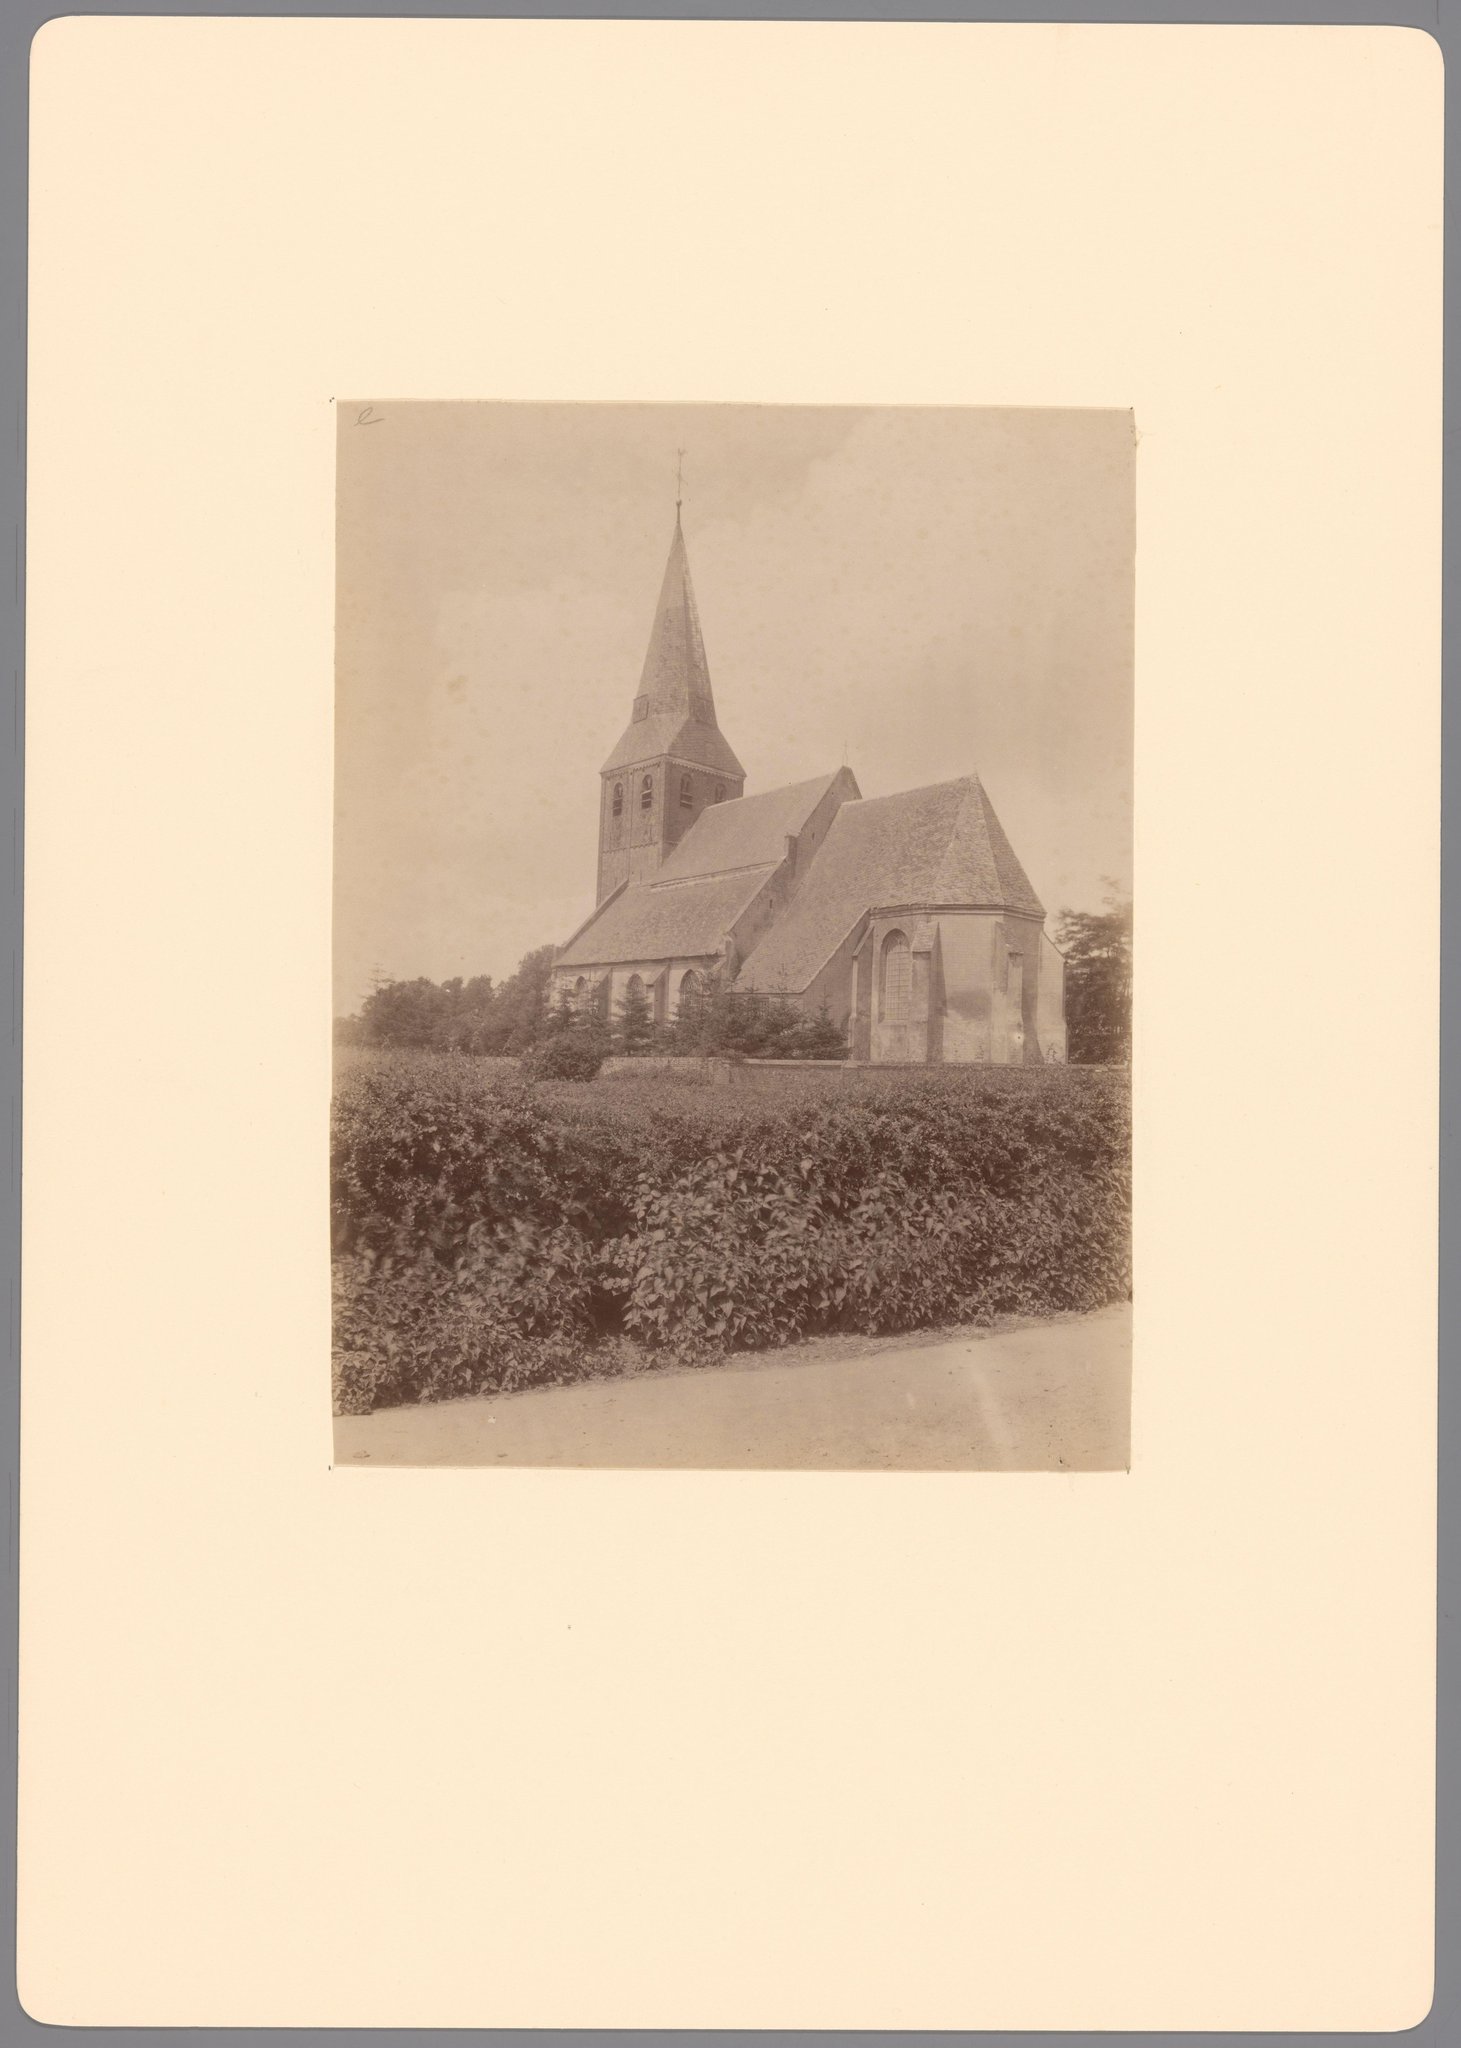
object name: photograph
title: Gezicht op de Remigiuskerk te Duiven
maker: anoniem (monumentenzorg)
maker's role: fotograaf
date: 1905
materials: cardboard, photographic support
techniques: albumen print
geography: duiven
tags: church (exterior)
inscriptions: annotation: ‘Duiven R.K. Kerk’, annotation: ‘e’